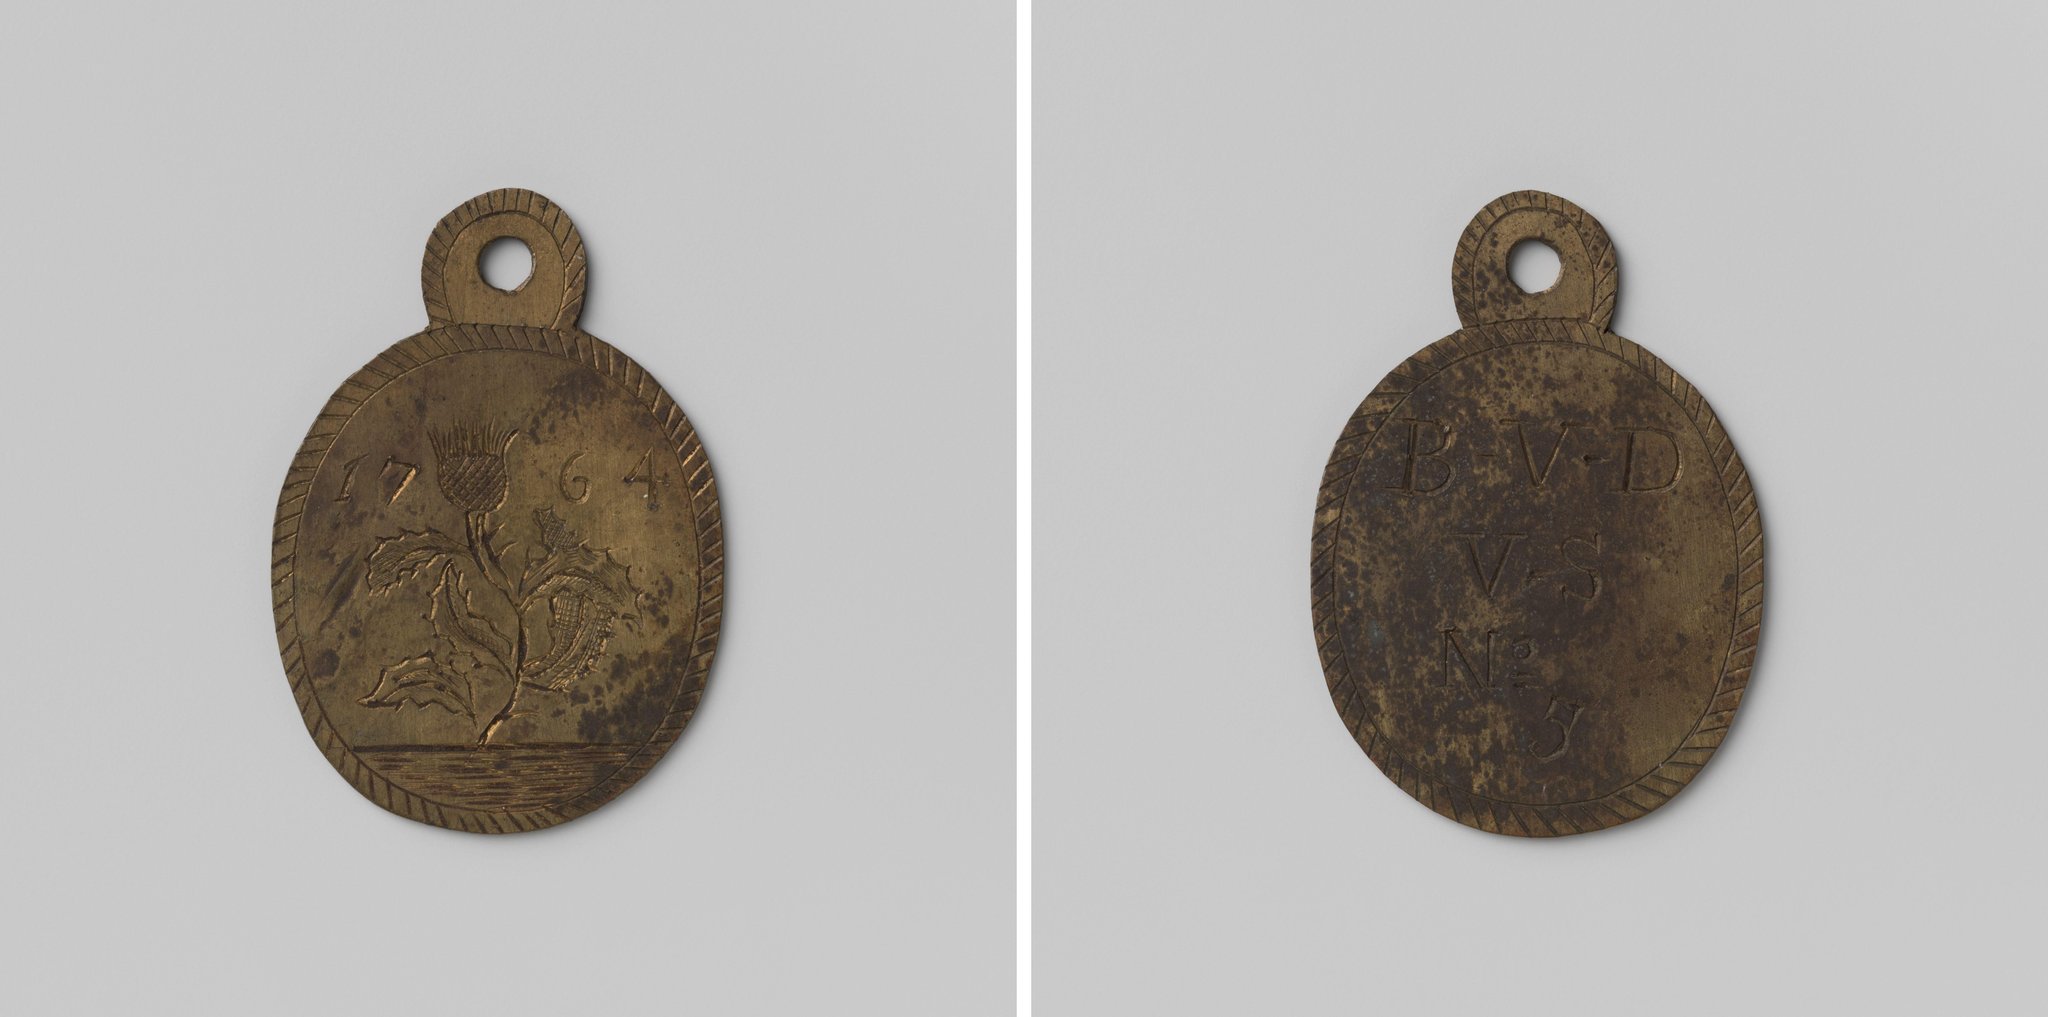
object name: identification medal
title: Armenpenning van het blok Vughterstraat te 's-Hertogenbosch, penning met no. 5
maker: Anonymous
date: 1764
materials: brass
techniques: engraving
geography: den bosch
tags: vughterstraat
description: Messing ovale penning aan draagoog. Voorzijde: distel tussen jaartal binnen gearceerde rand. Keerzijde: opschrift binnen gearceerde rand